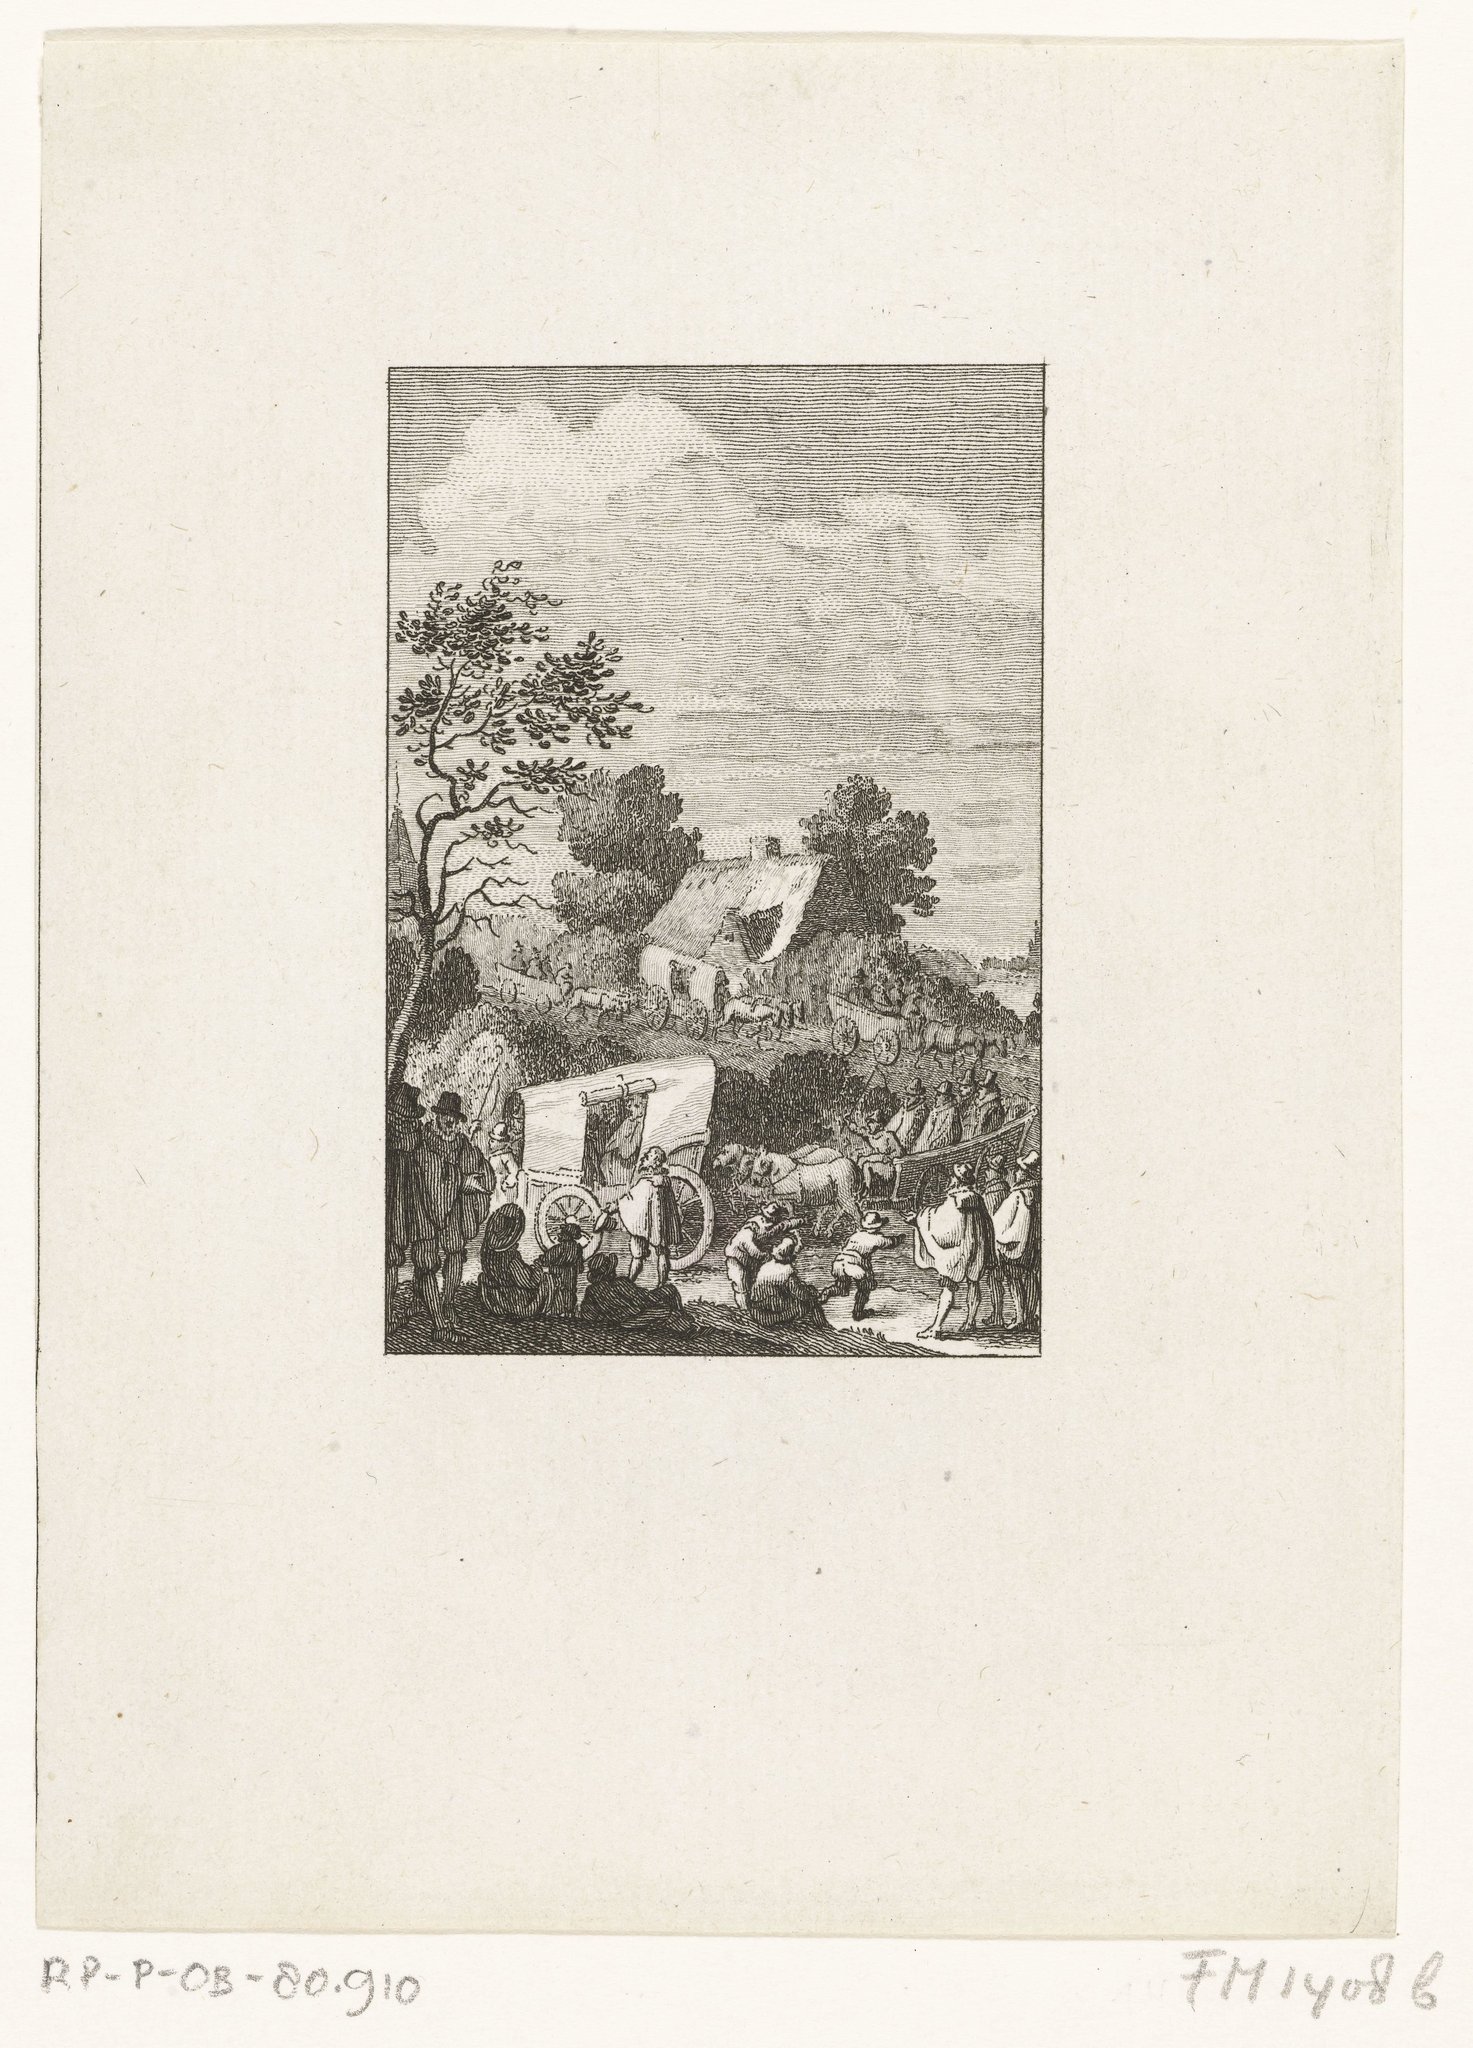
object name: history print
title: Uittocht van de remonstrantse predikanten, 1619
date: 1780-1795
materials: paper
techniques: etching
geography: northern netherlands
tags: banishment, exile, the hague, waalwijk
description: Gebruikt als illustratie in: J. Fokke, Geschiedenissen der Vereenigde Nederlanden voor de vaderlandsche jeugd, Johannes Allart, Amsterdam 1783-1795, 25 delen, dl. VII, pl. III. Staat vóór de letter. Gekopieerd naar een deel van de voorstelling in de prent van Claes Jansz. Visscher (II) (FMH 1410).